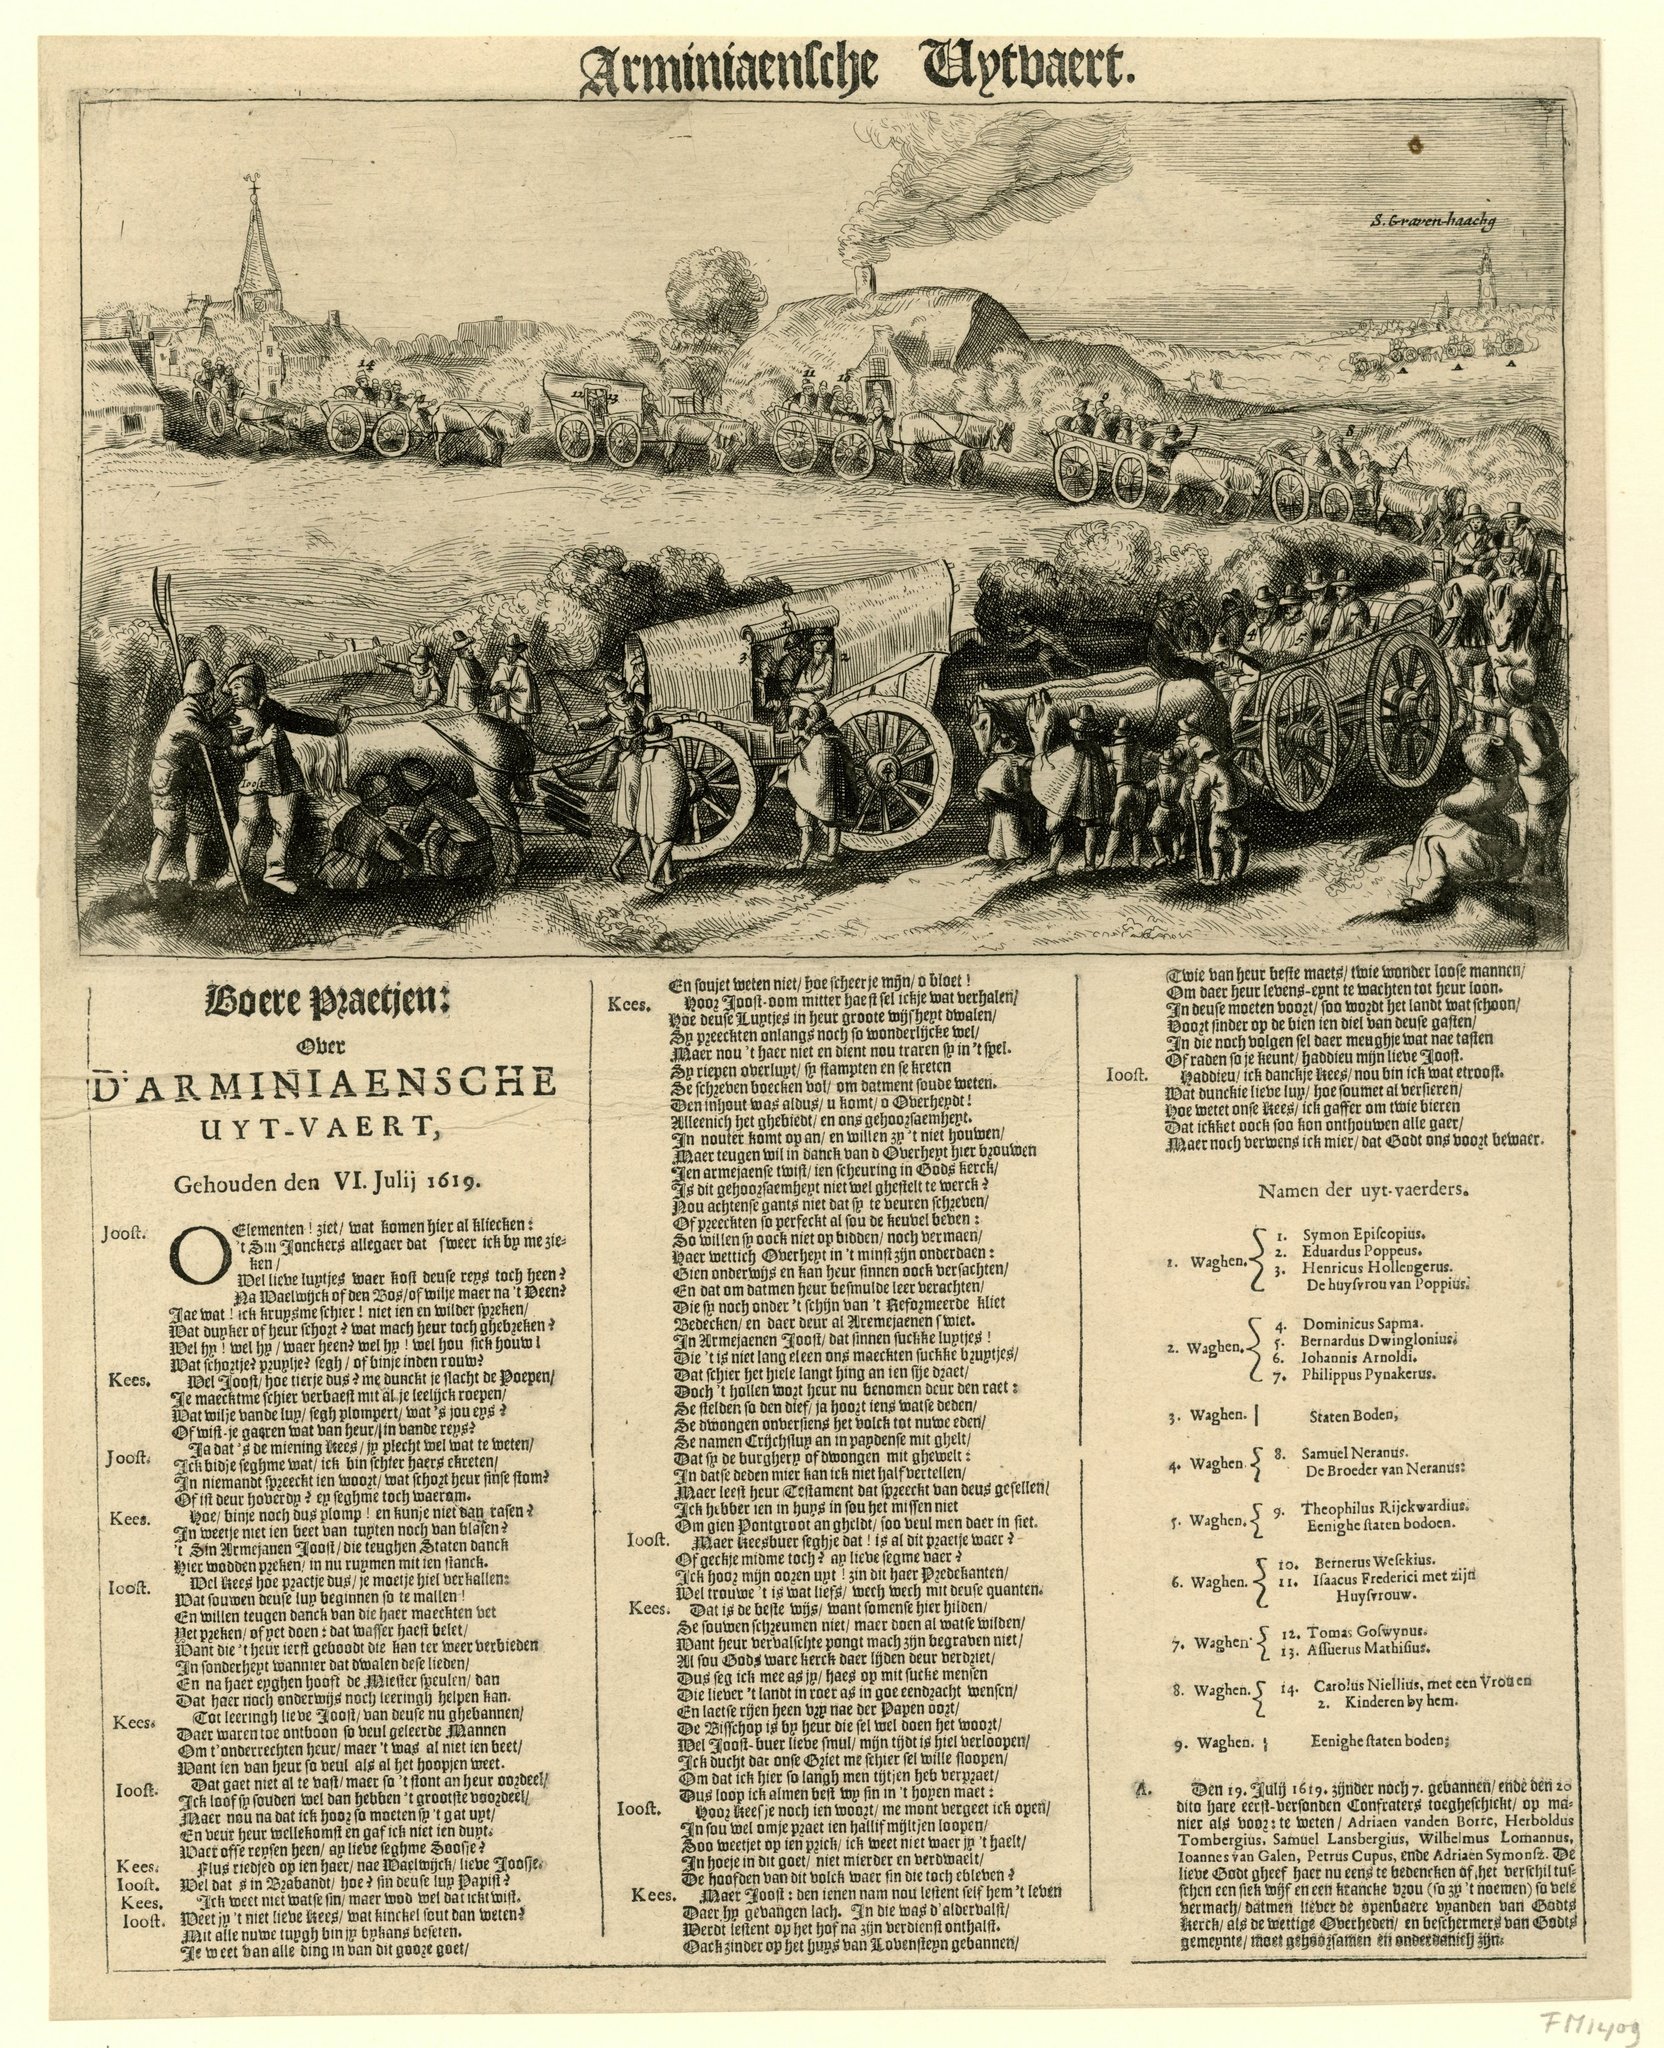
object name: cartoon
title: Arminiaensche Uytvaert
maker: Anonymous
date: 1619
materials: paper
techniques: engraving, etching, letterpress printing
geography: northern netherlands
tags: banishment, exile, the hague, waalwijk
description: Spotprent op de uittocht van de remonstranten uit 's-Gravenhage op 6 juli 1619 na de veroordeling door de Synode. Onder de prent de samenspraak tussen twee boeren genaamd Kees en Joost getiteld 'Boere Praetjen: over D'Arminiaensche Uyt-Vaert, Gehouden den VI. Julij 1619'. Rechts een lijst van de wagens met de namen van de passagiers.